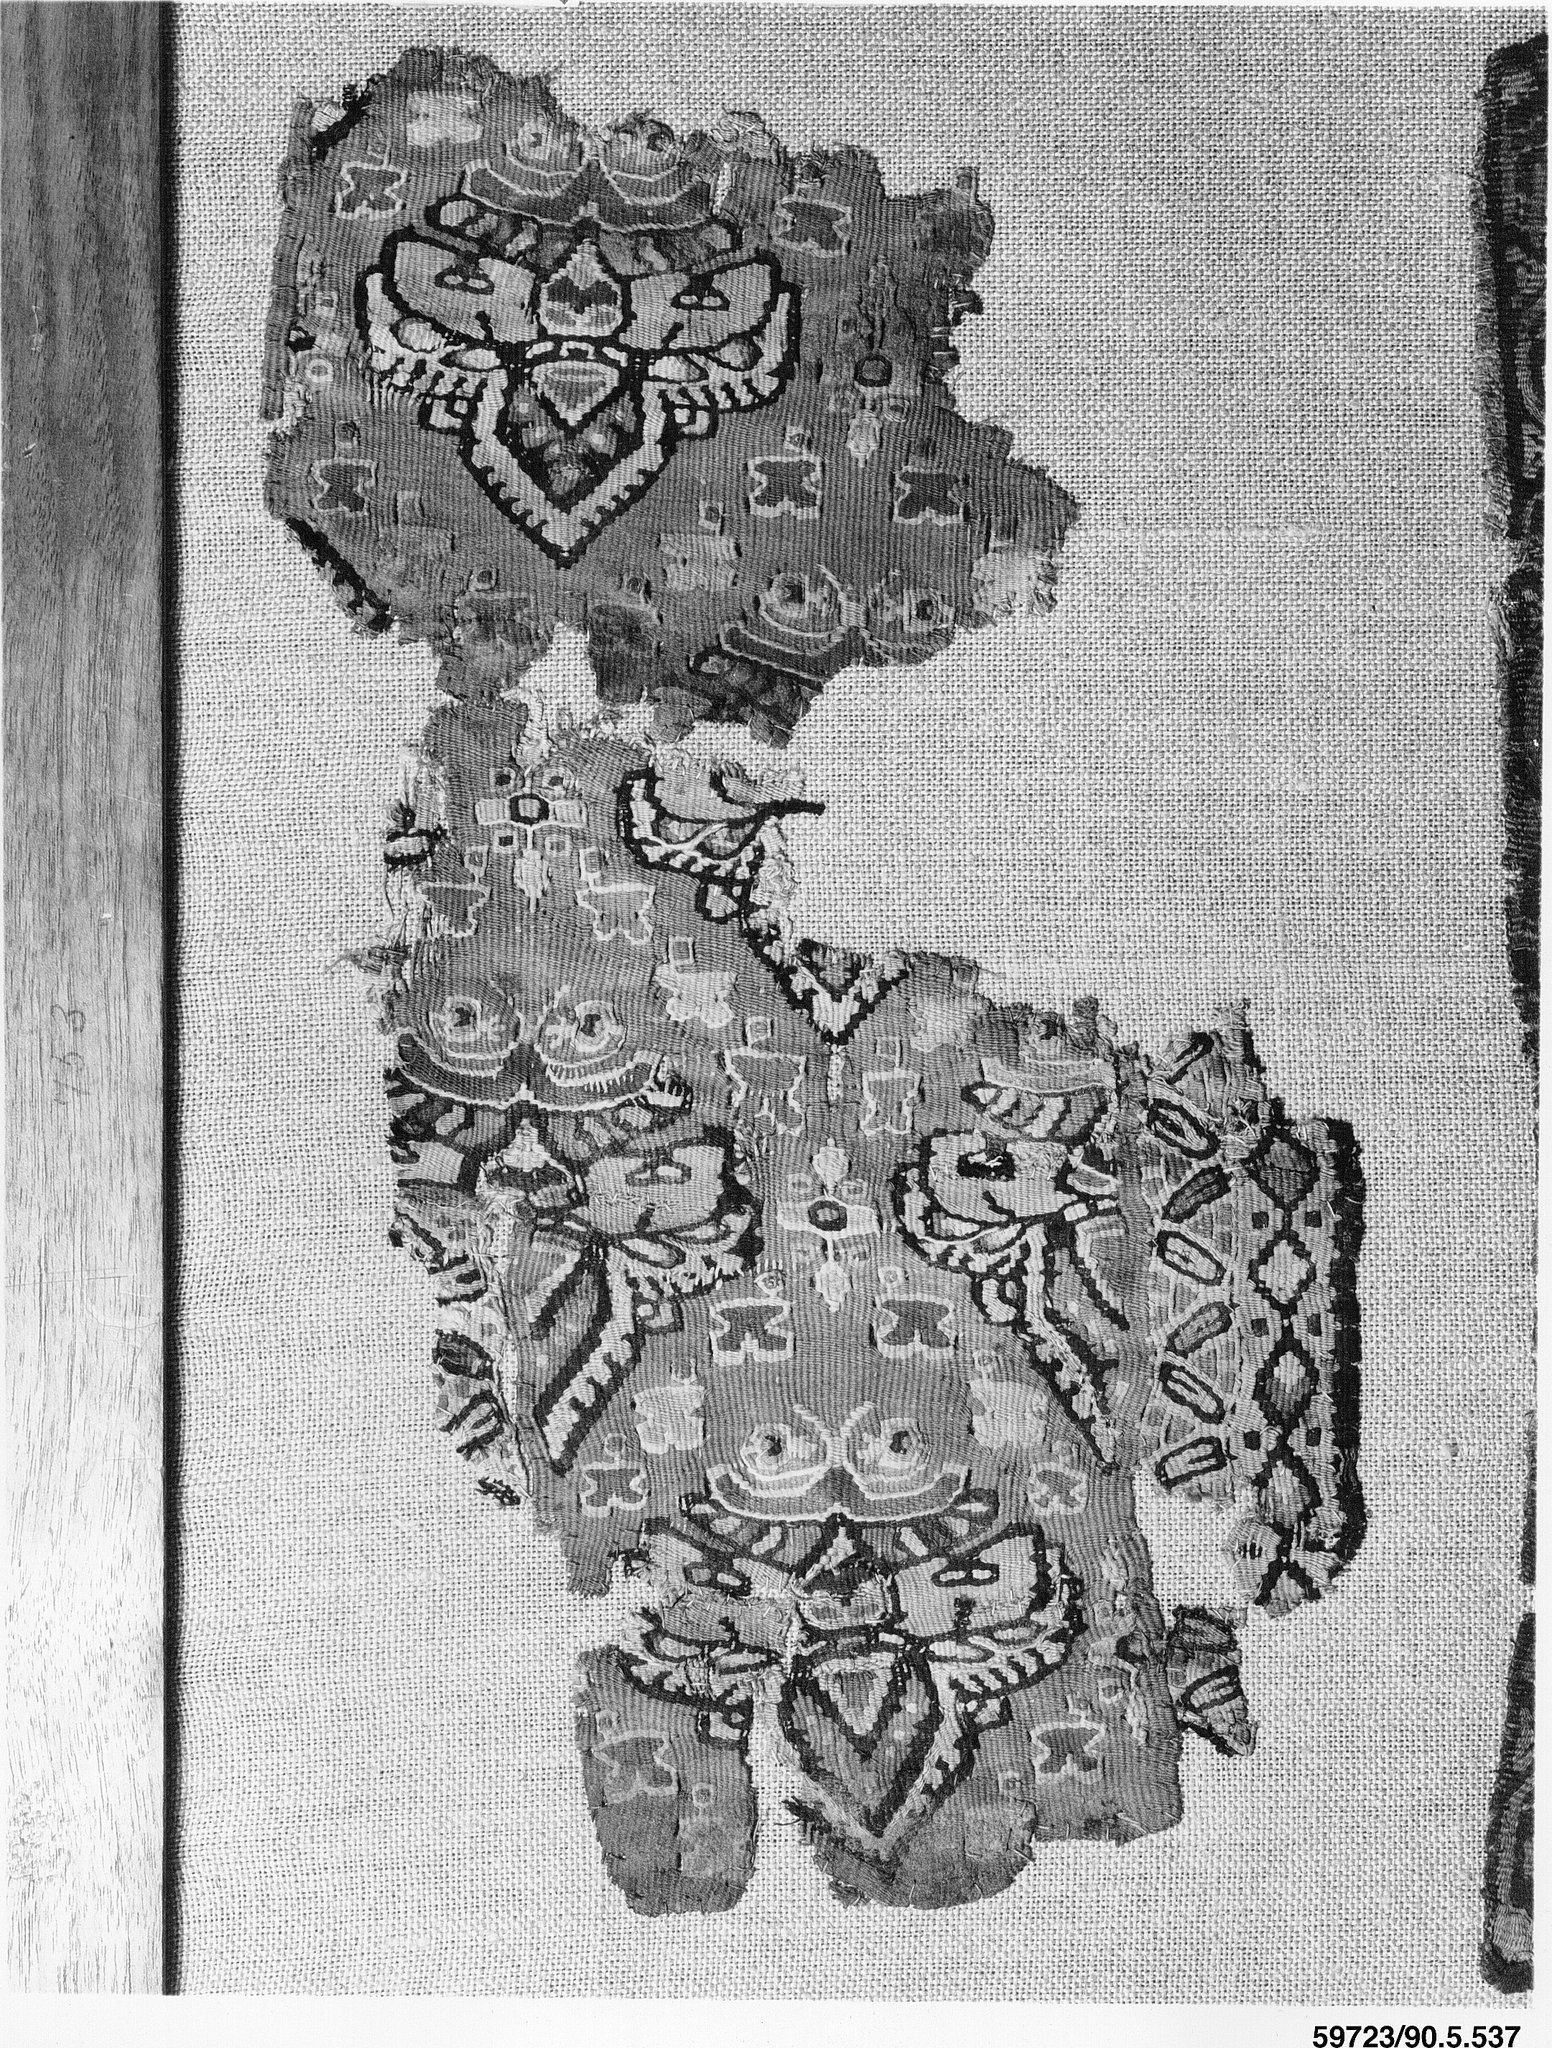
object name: textile fragment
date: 501-700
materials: linen, wool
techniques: weave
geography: egypt